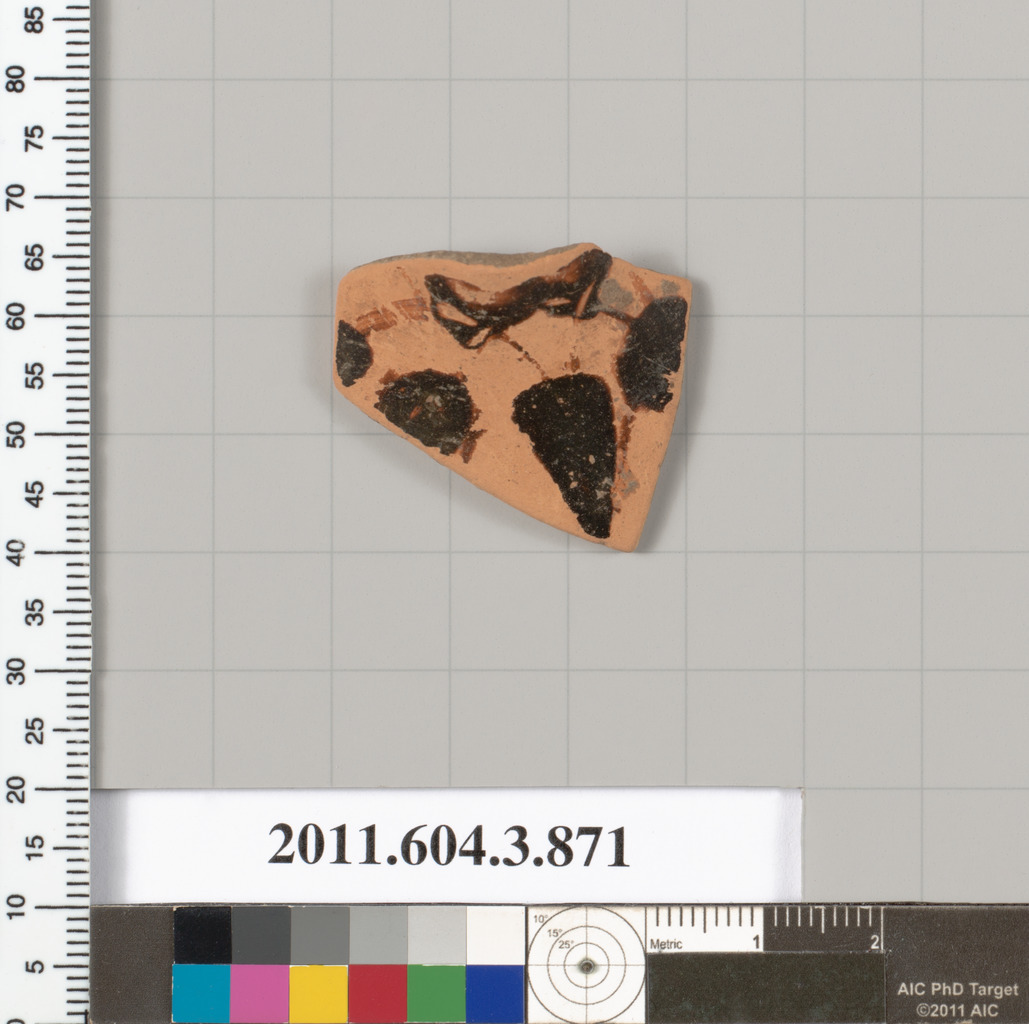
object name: lekythos fragment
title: Terracotta fragment of a lekythos (oil flask)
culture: greek, attic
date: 534-468 BCE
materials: terracotta